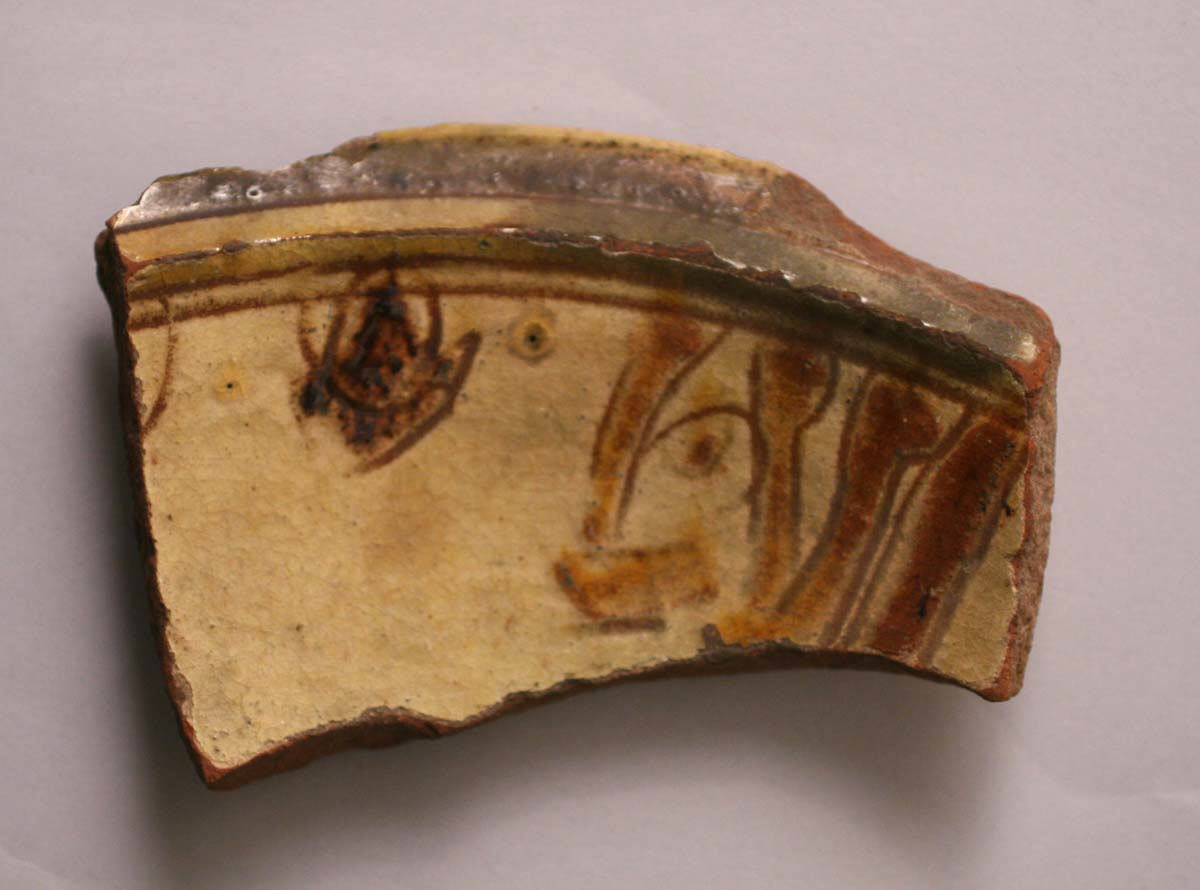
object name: fragment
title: Ceramic Fragment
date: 1301-1500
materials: earthenware, glaze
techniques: coloring, incising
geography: egypt